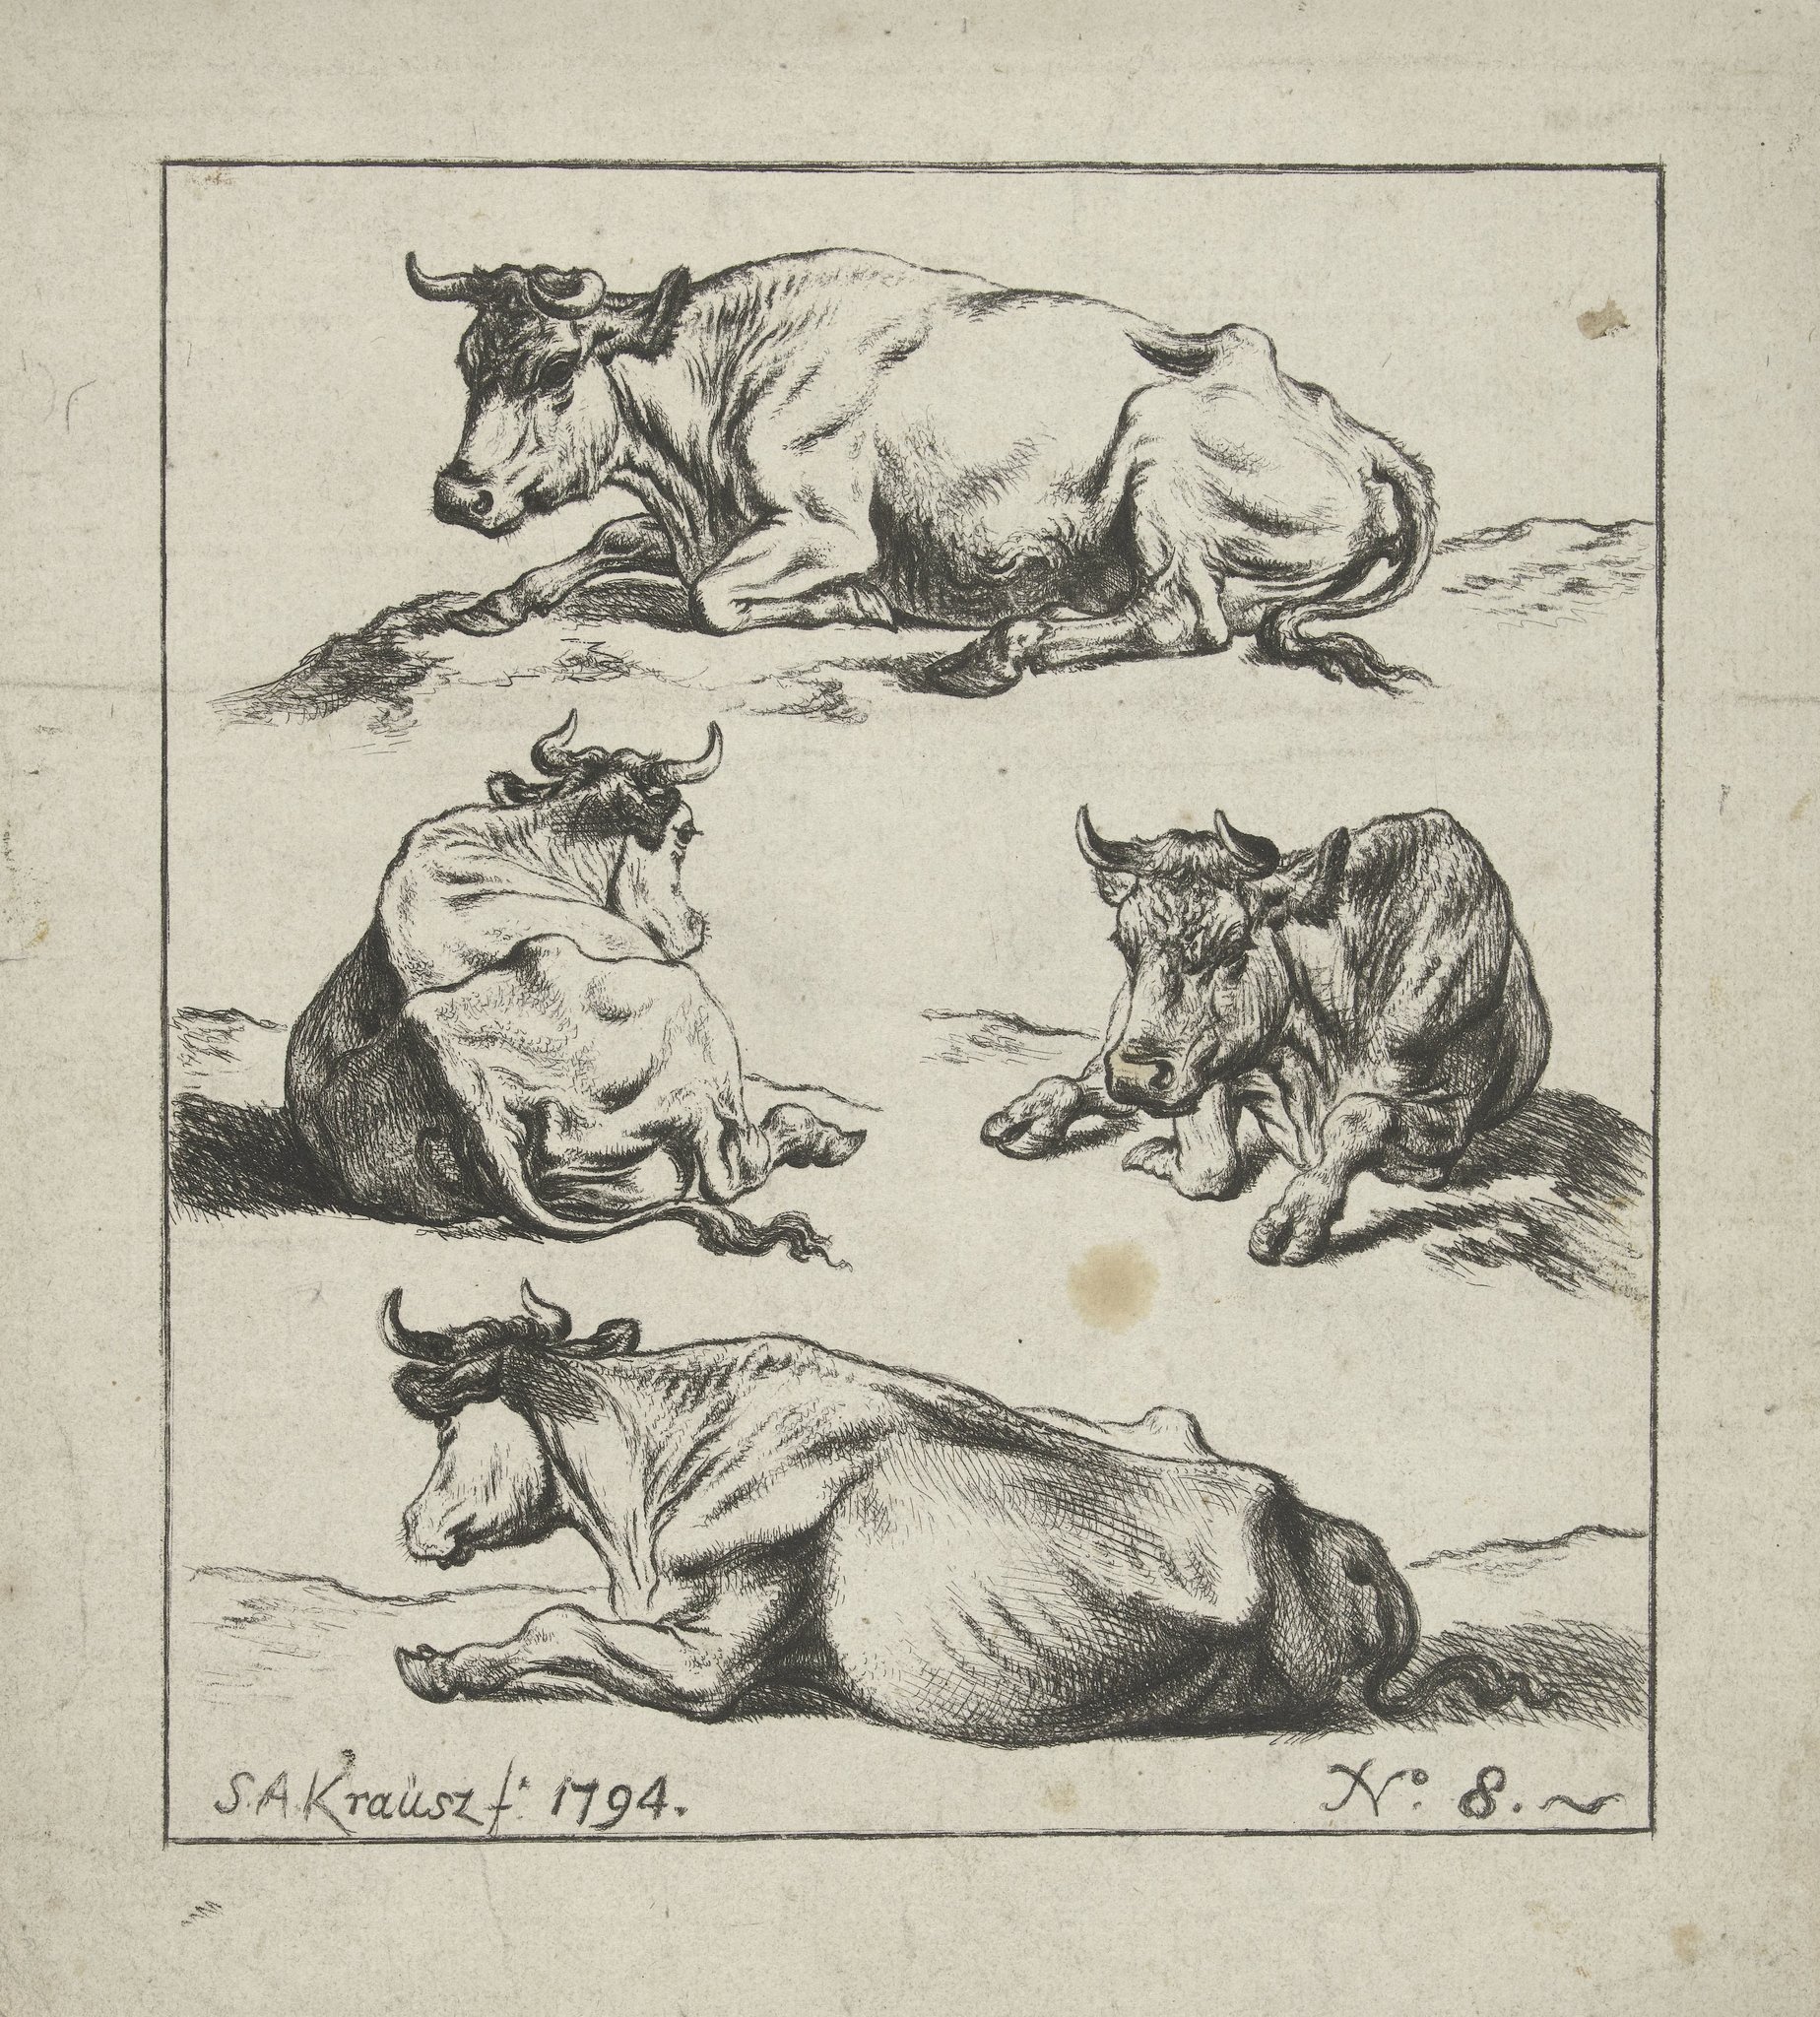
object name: print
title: Studie van liggende koeien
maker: simon andreas krausz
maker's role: draughtsman, print maker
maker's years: 1760-1825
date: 1794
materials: paper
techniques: etching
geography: the hague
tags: cow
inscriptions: collector's mark: Lugt 2228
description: Studie van liggende koeien van voren en opzij gezien. De prent maakt deel uit van een serie prenten met studies van koeien en schapen.